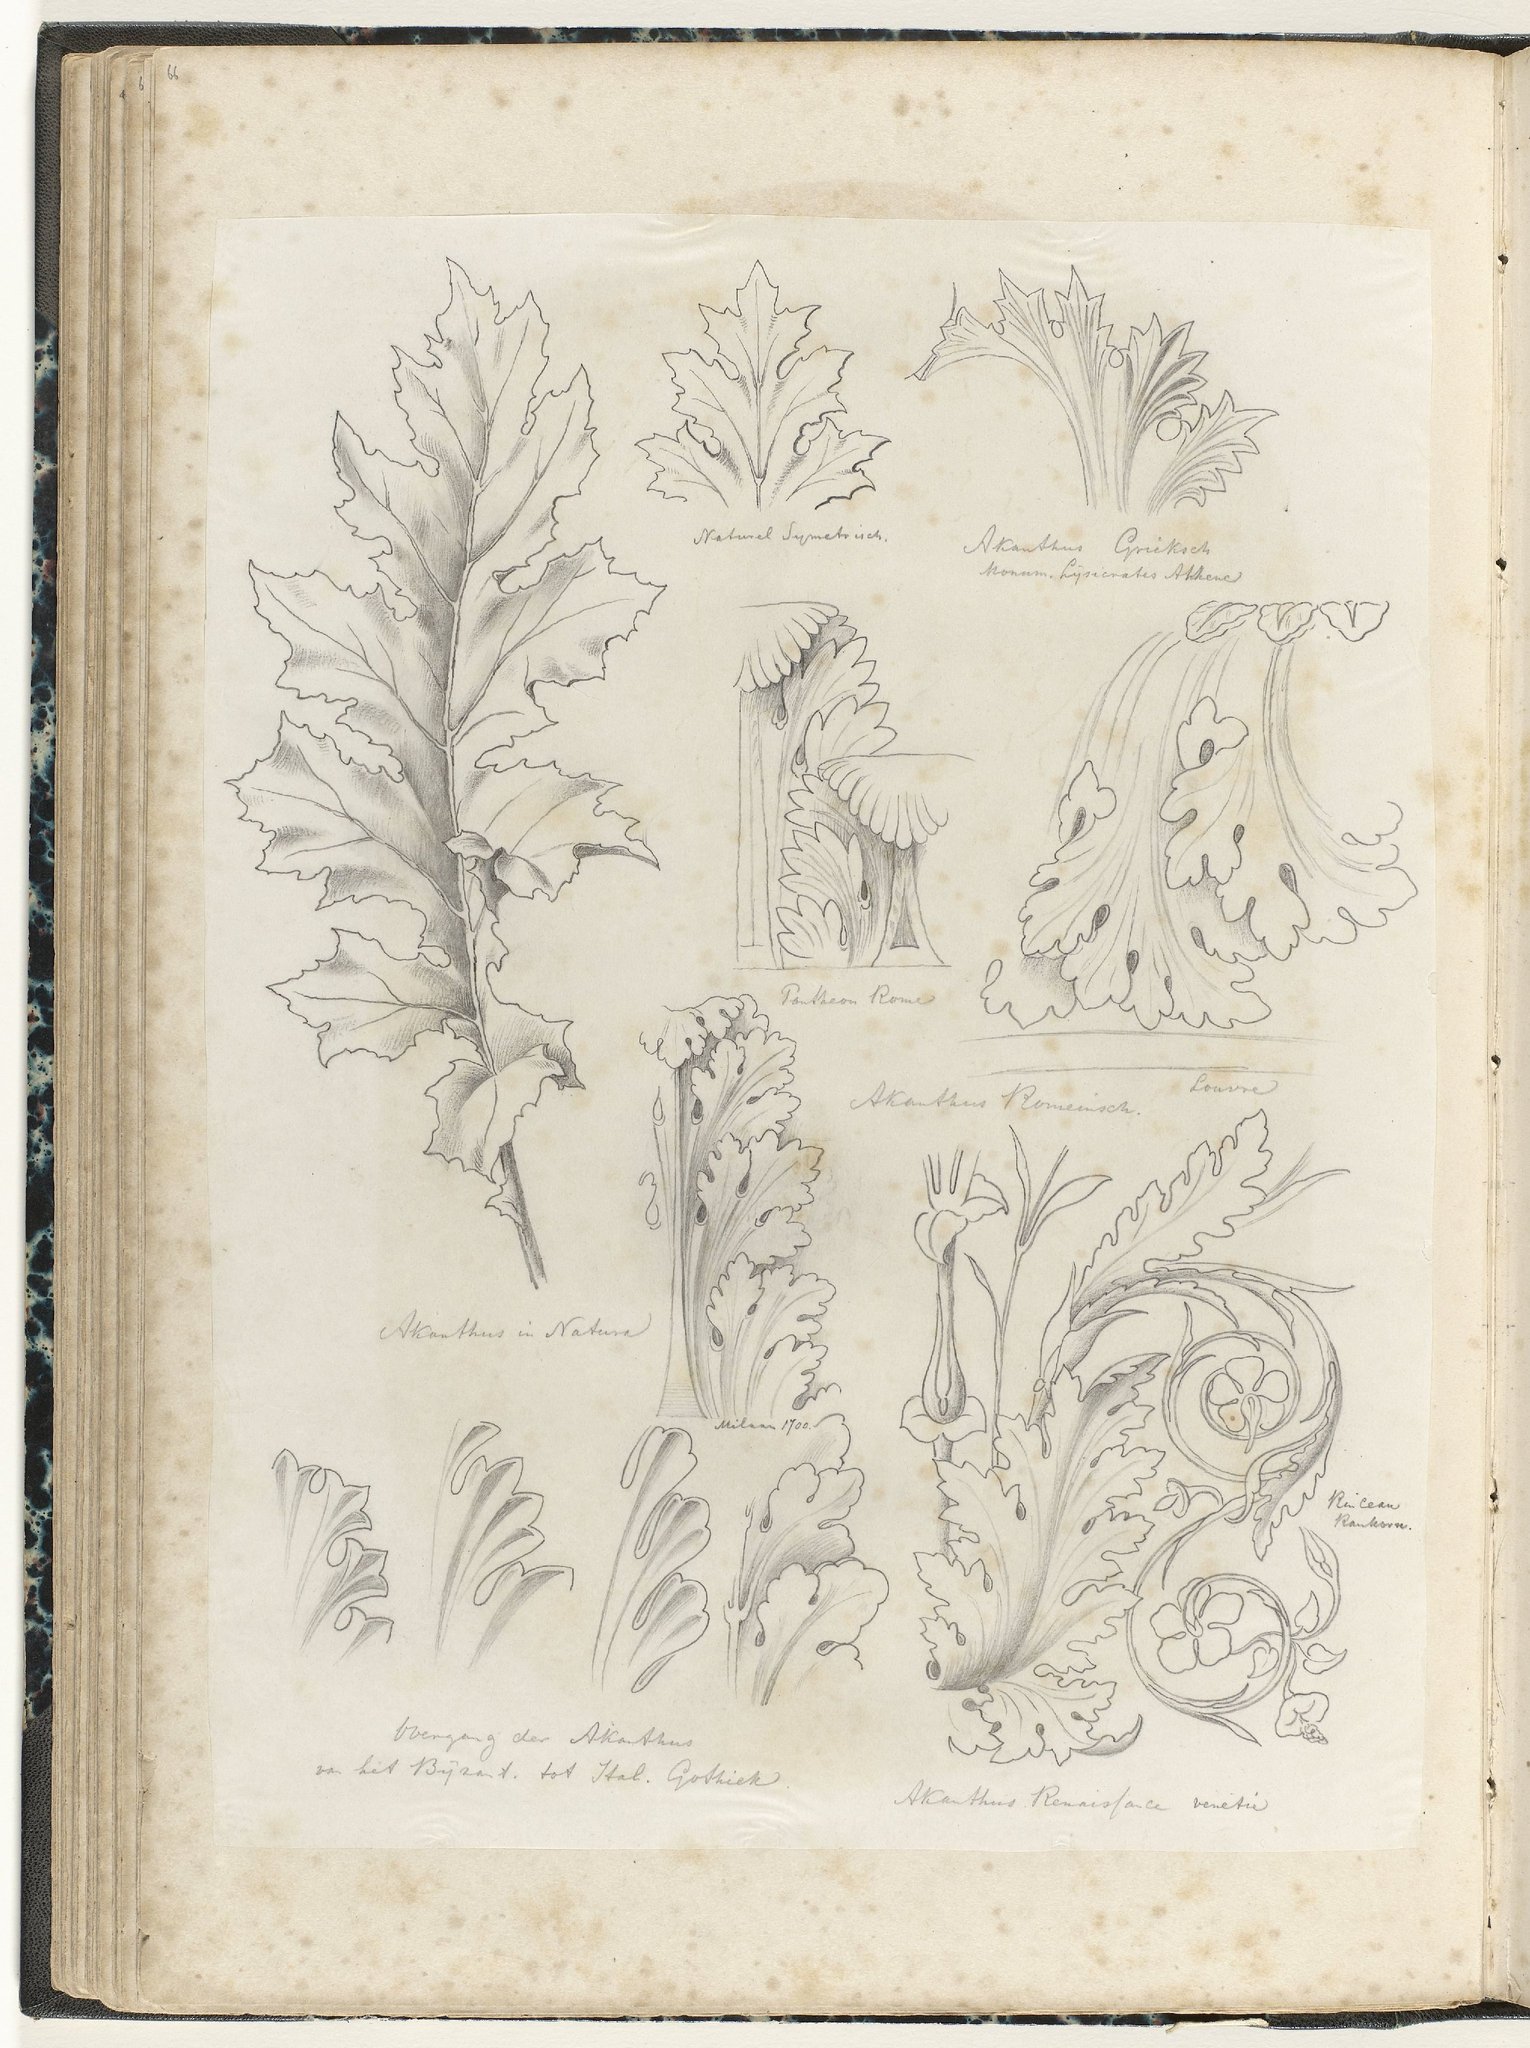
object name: drawing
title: Elf motieven van acanthusbladeren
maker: Anonymous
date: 1866-1900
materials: pencil, paper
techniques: drawing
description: Bij de bladeren is geschreven naar welk voorbeeld de tekening is gemaakt.